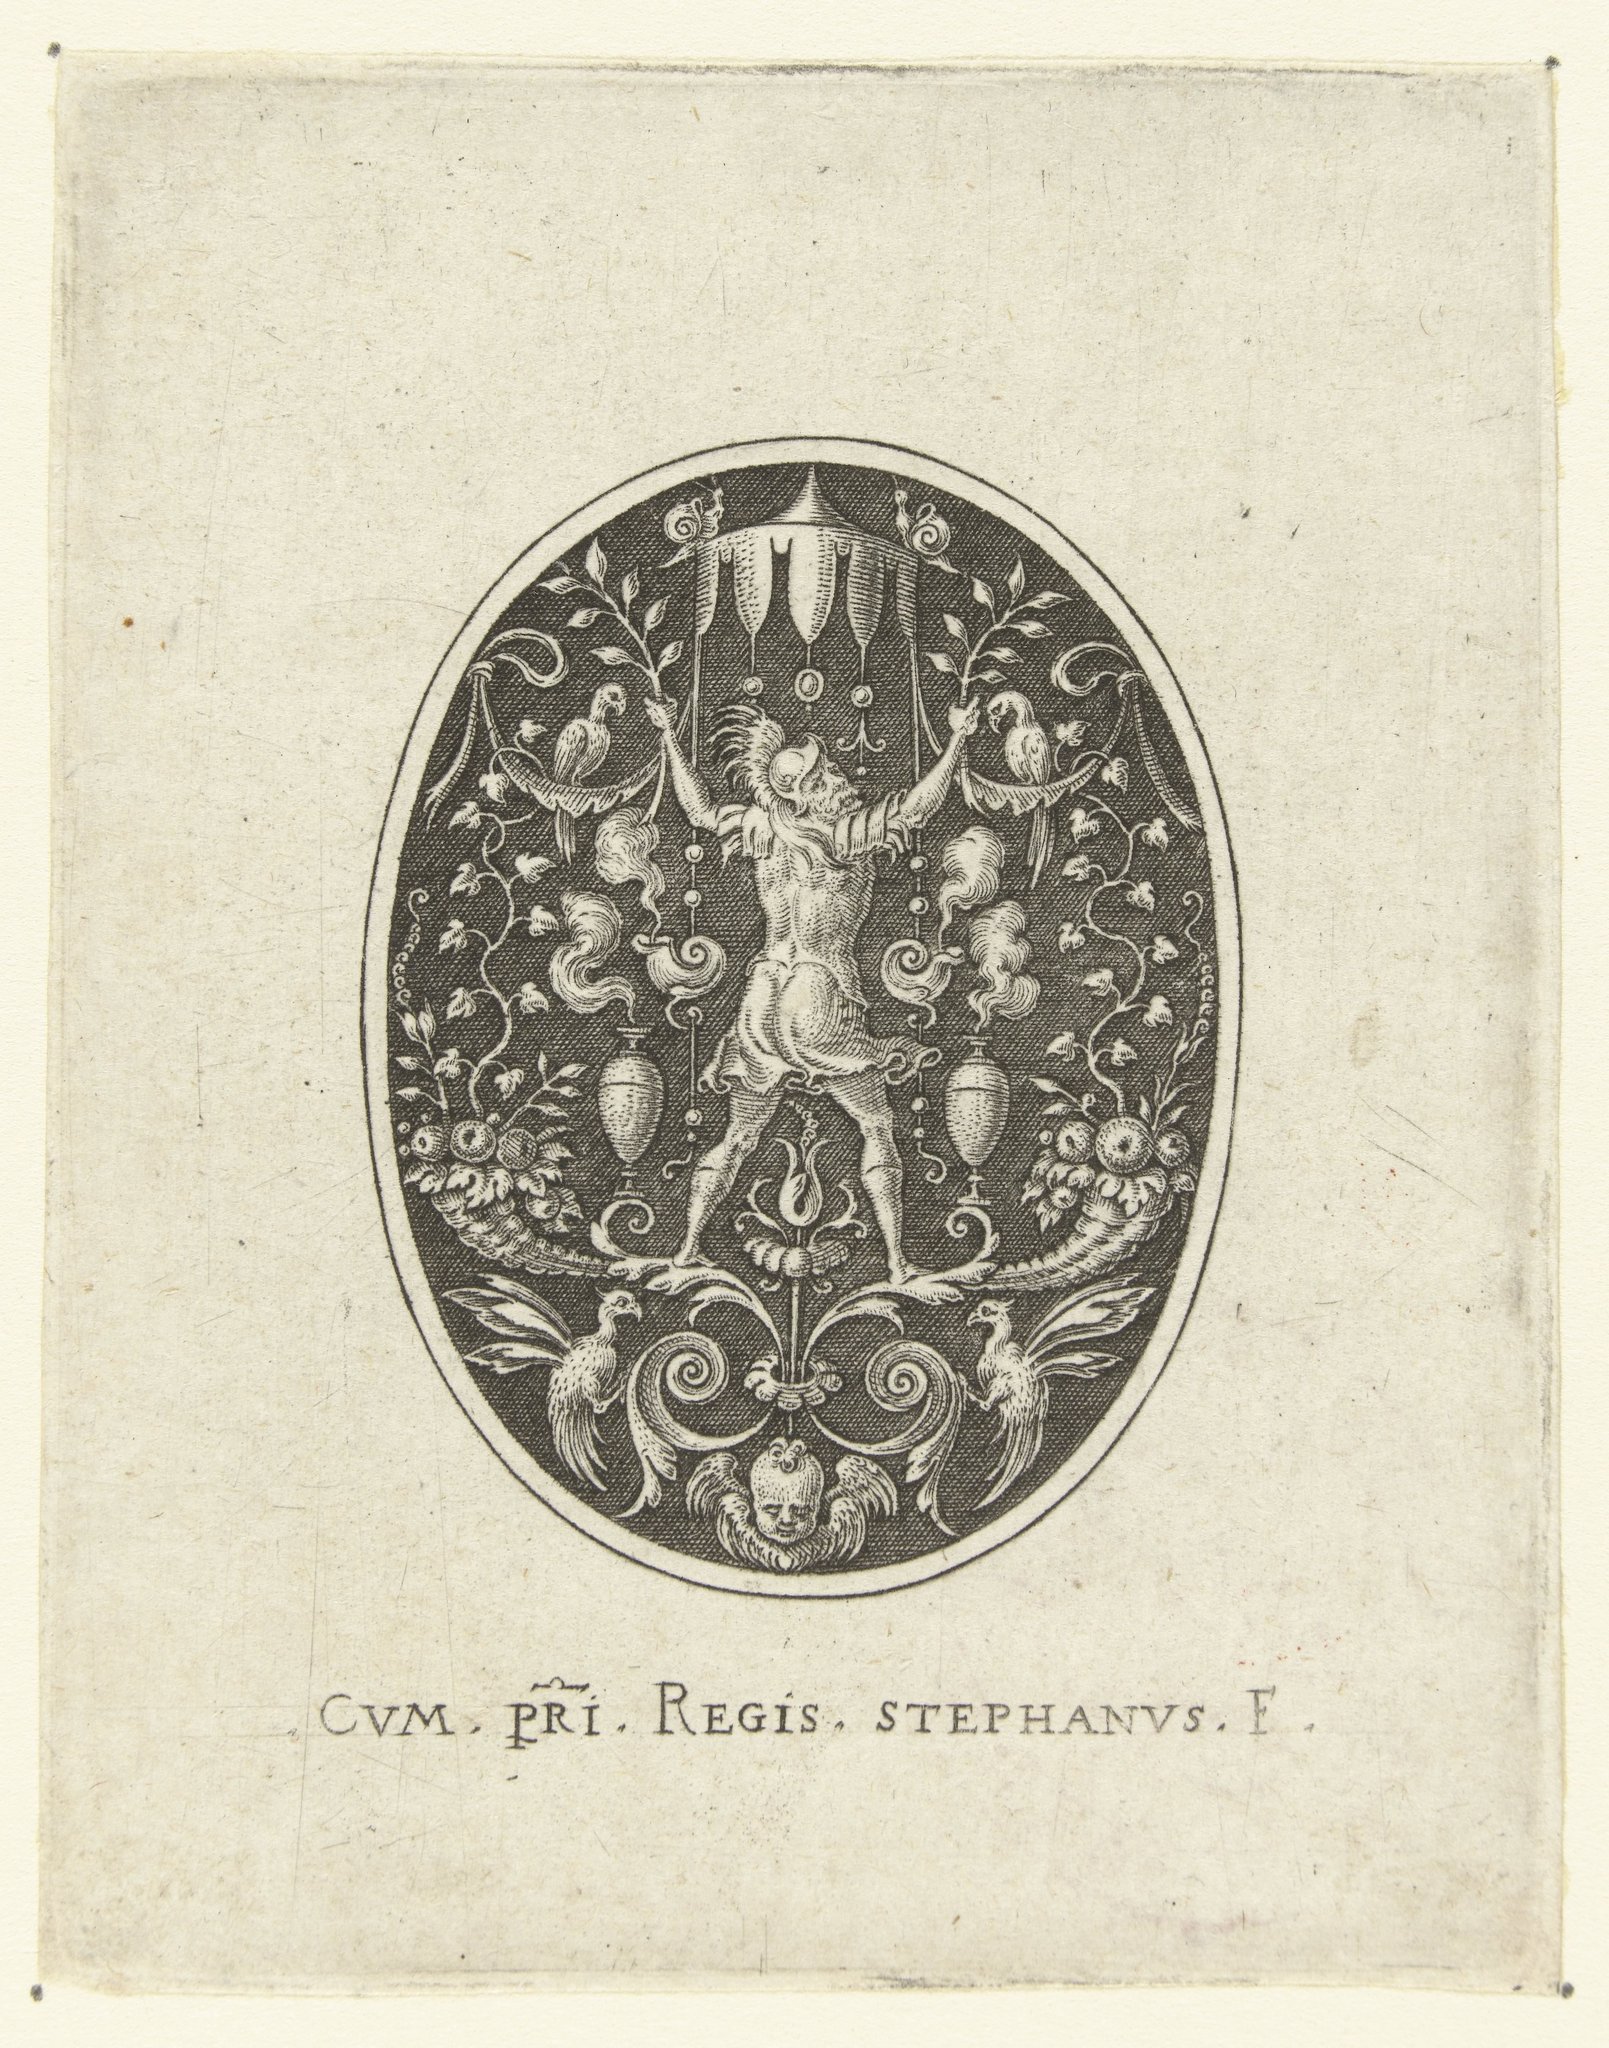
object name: ornament print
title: Mars onder een baldakijn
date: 1528-1583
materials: paper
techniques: engraving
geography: france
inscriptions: collector's mark: Lugt 240